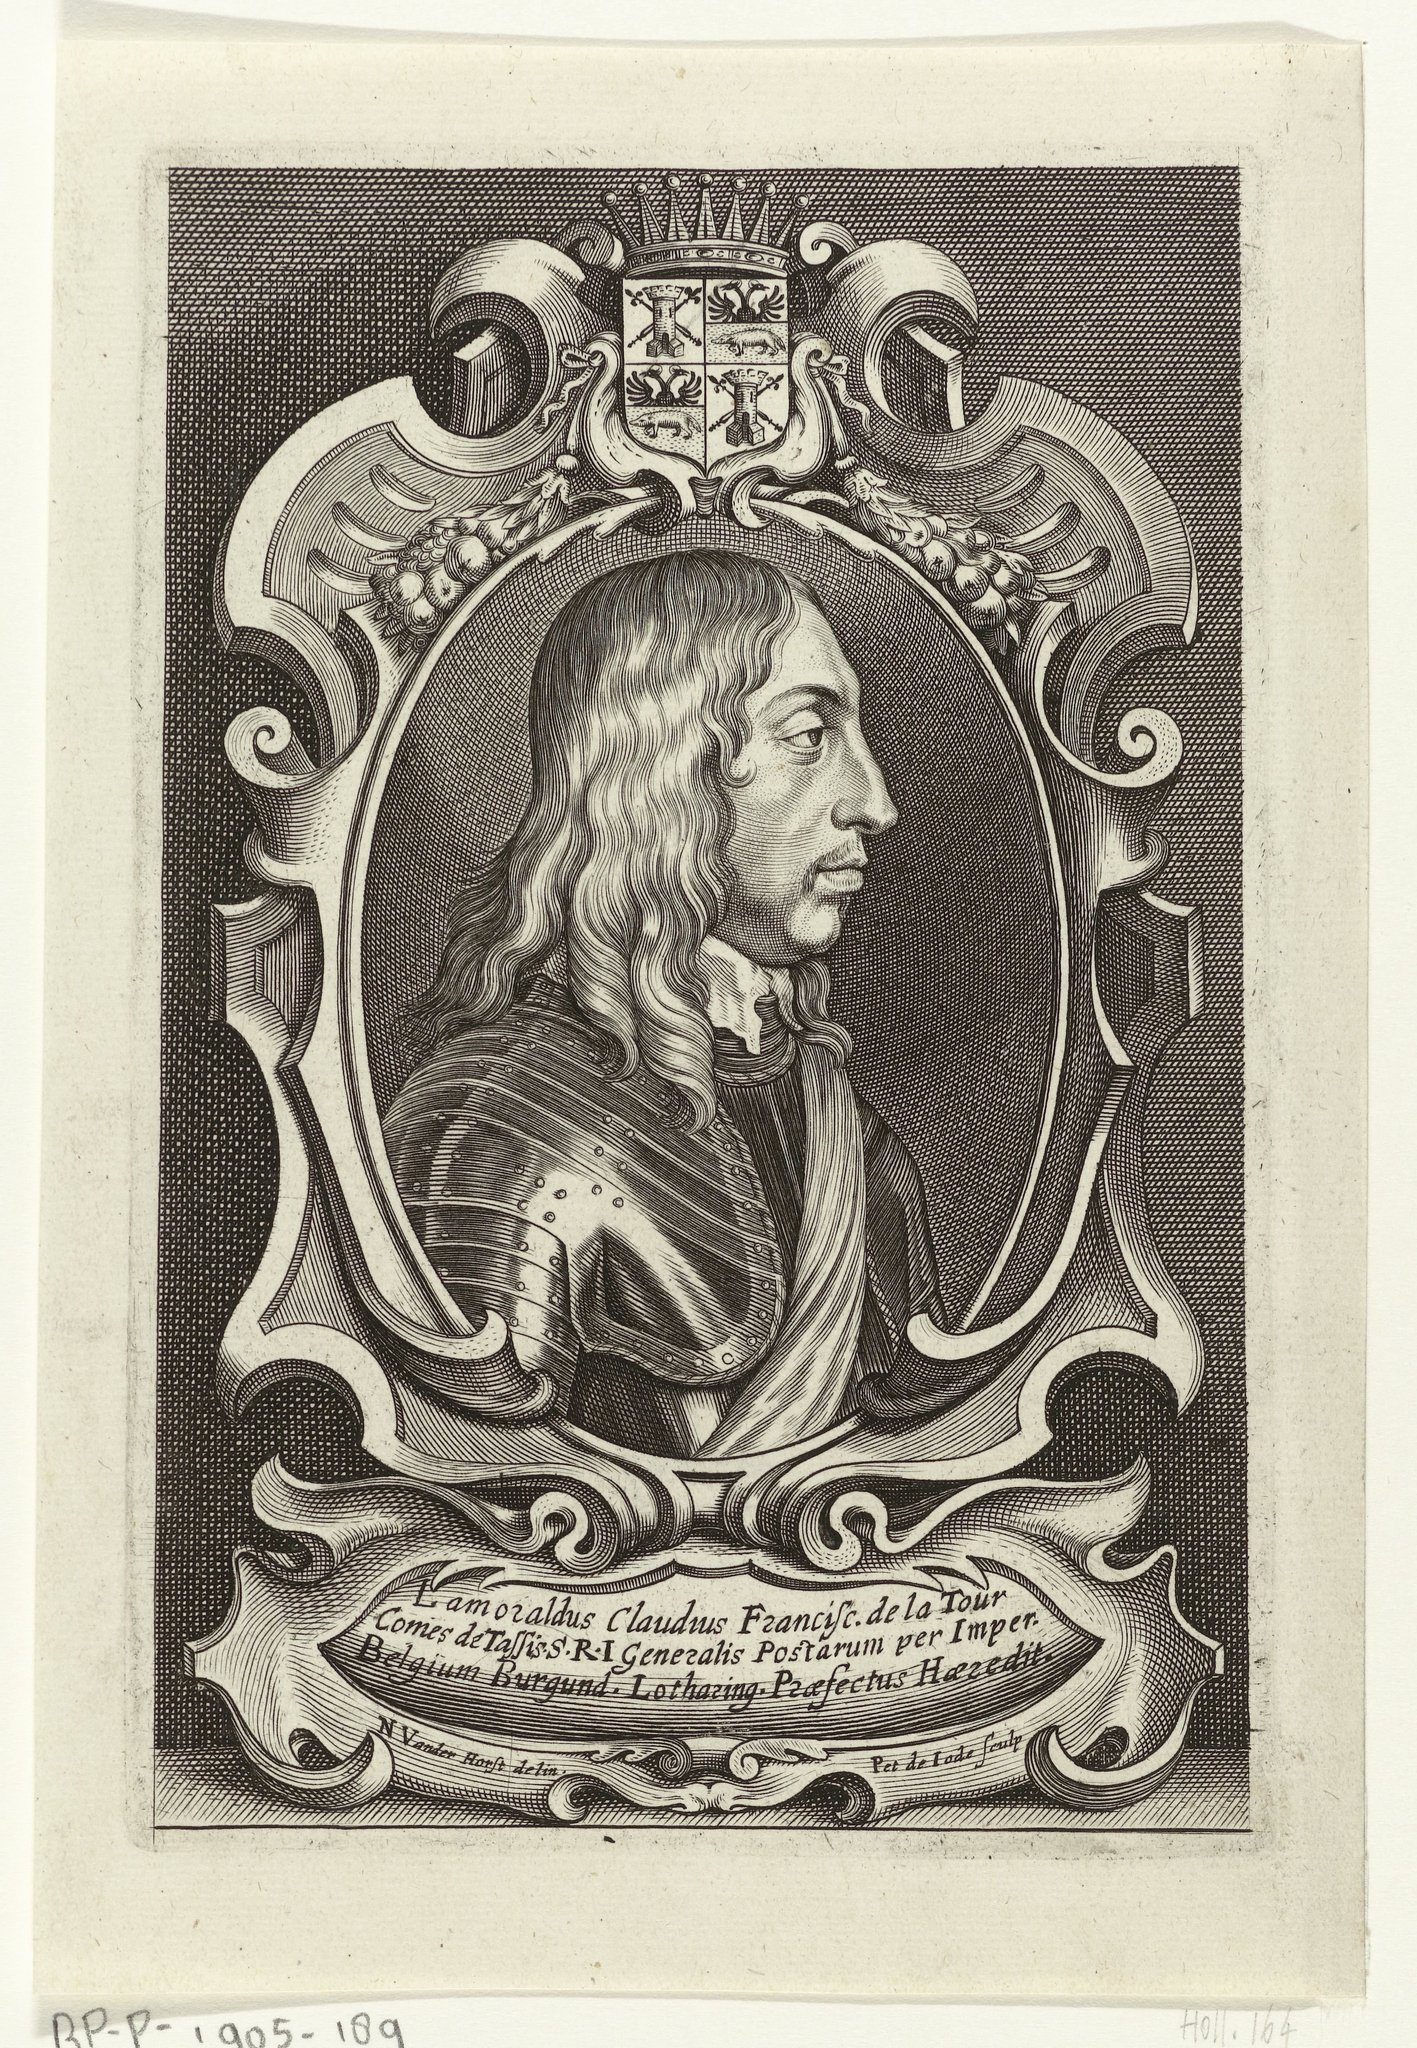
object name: print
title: Portret van Lamoraldus Claudius Franciscus de la Tour, graaf van Tassis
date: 1628-1670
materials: paper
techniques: engraving, etching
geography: antwerp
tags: lamoraldus claudius franciscus de la tour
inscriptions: collector's mark: Lugt 2228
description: Cartouche met busteportret van Lamoraldus Claudius Franciscus de la Tour. de cartouche is bekroond met het wapenschild van de geportretteerde. In het kader een drieregelig onderschrift in het Latijn.